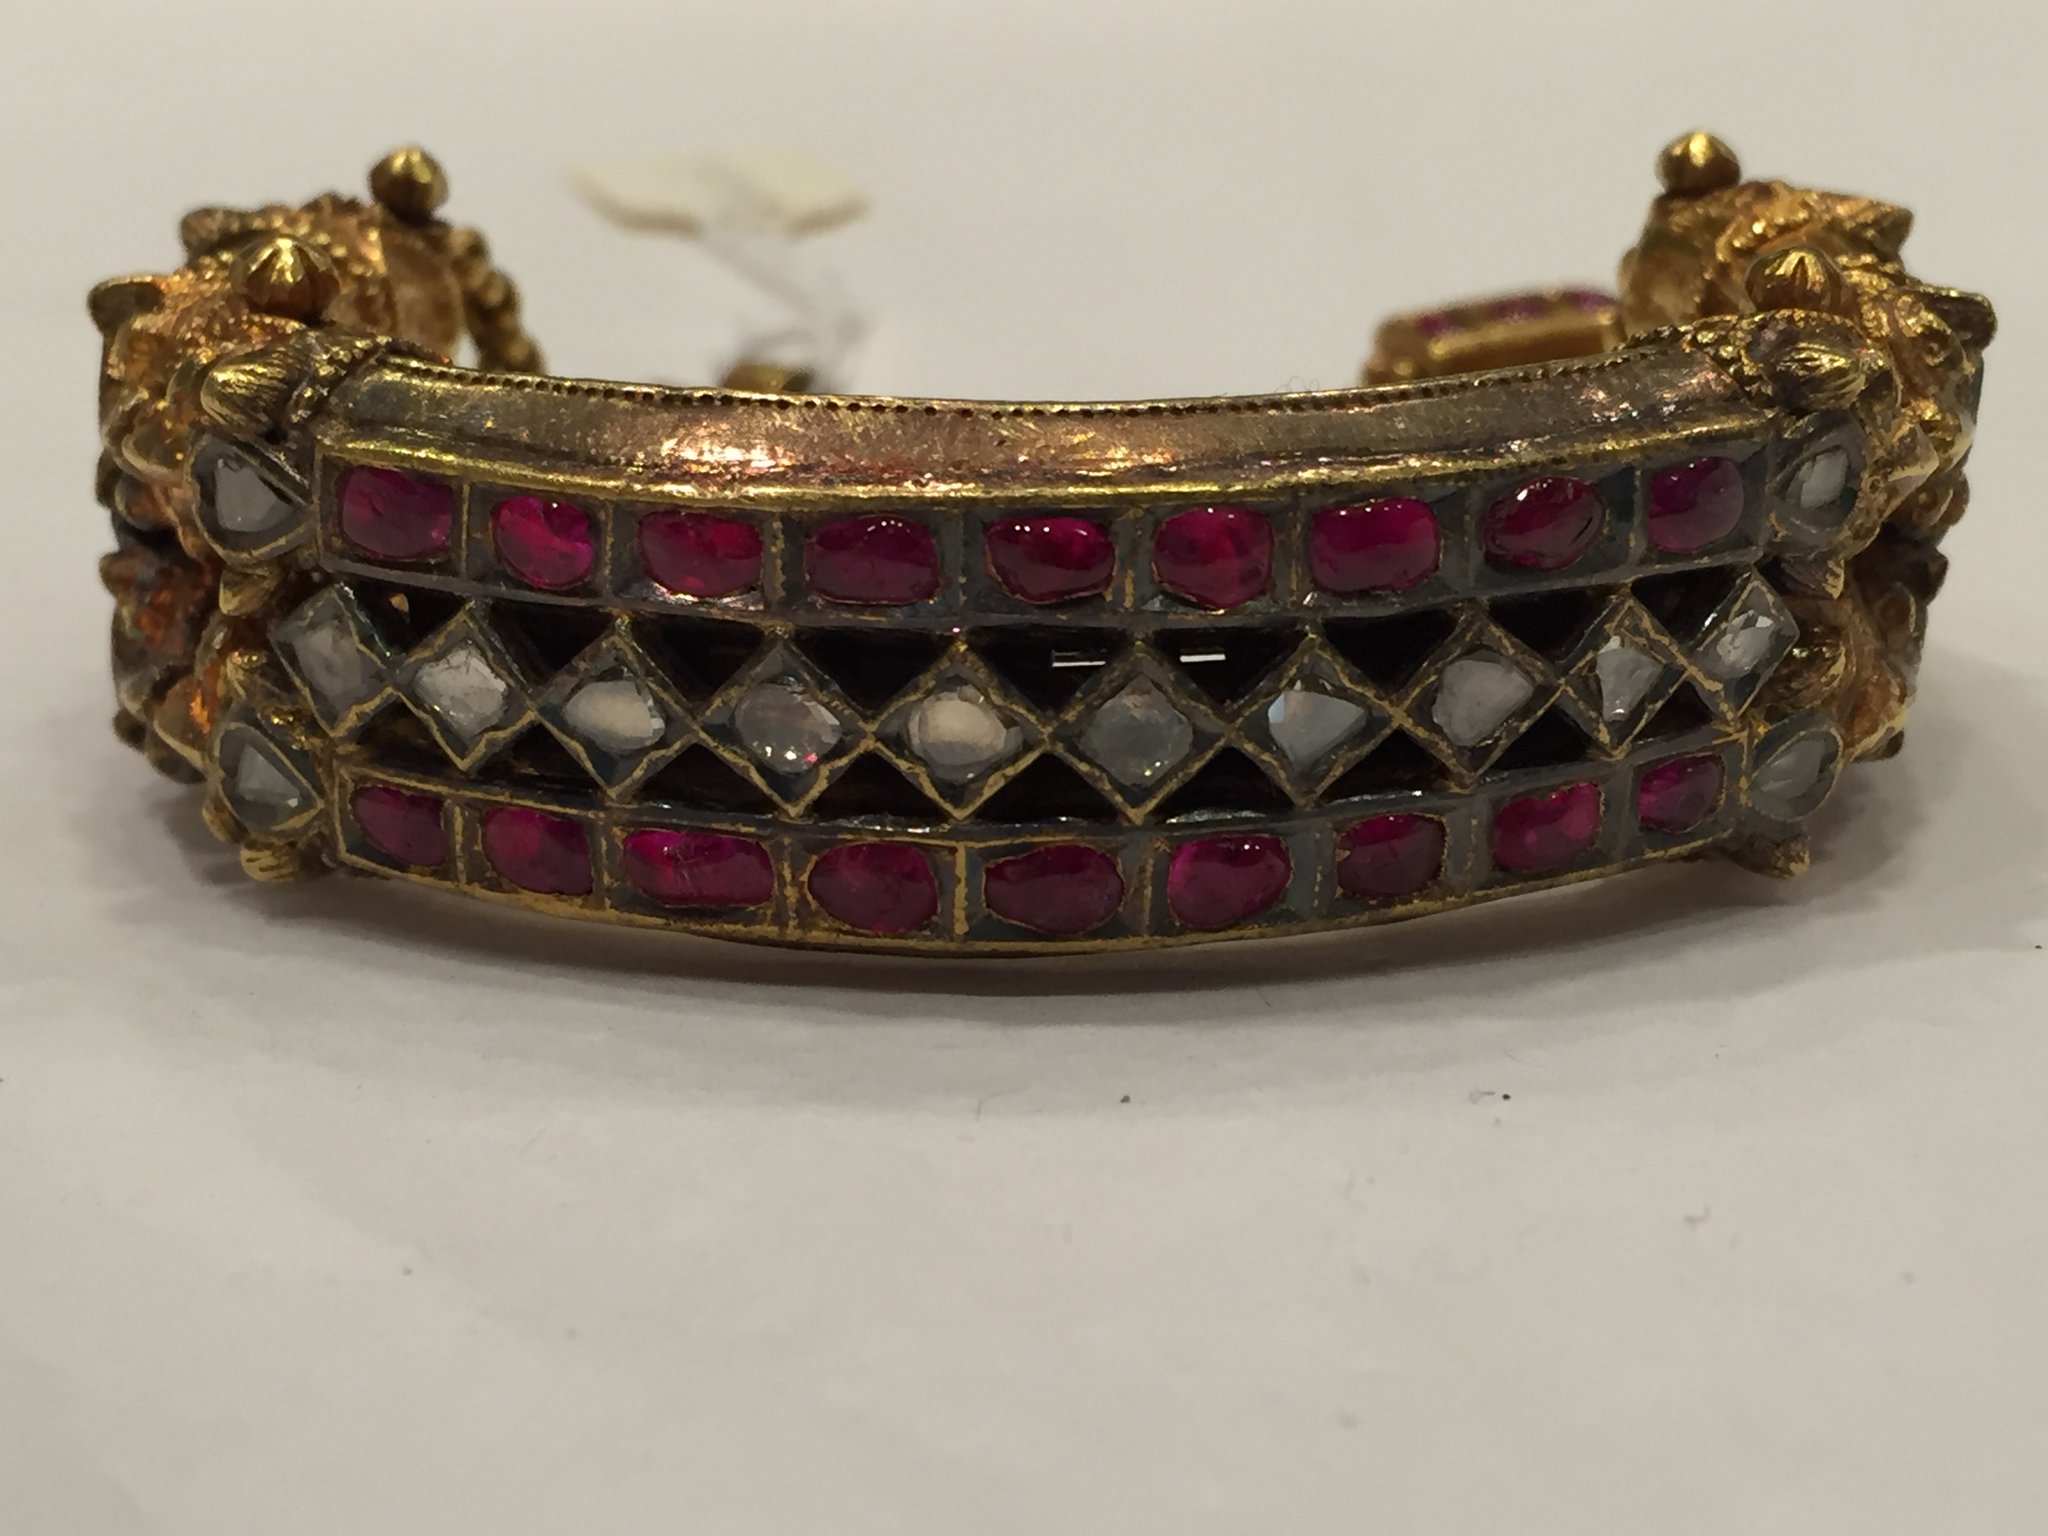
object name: bracelet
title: Bracelet with Lion Hinges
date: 1801-1900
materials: diamond, gold, gemstone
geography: india